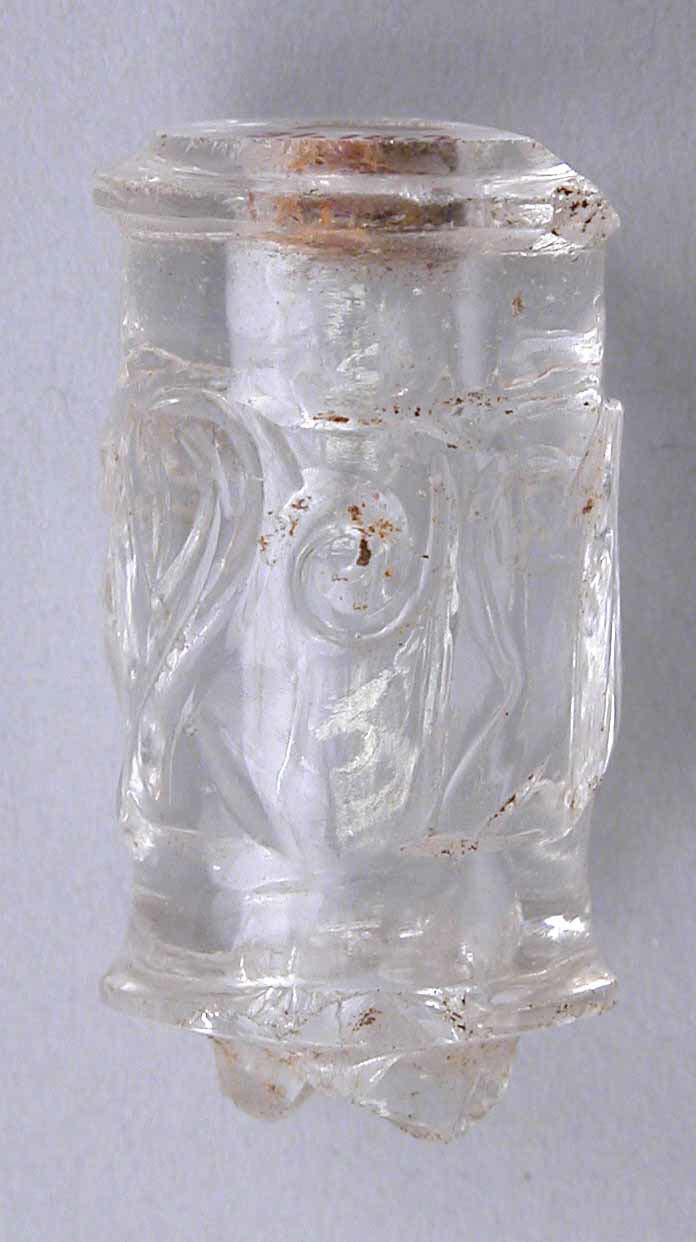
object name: flask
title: Crystal Flask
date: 901-1000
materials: quartz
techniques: carving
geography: egypt